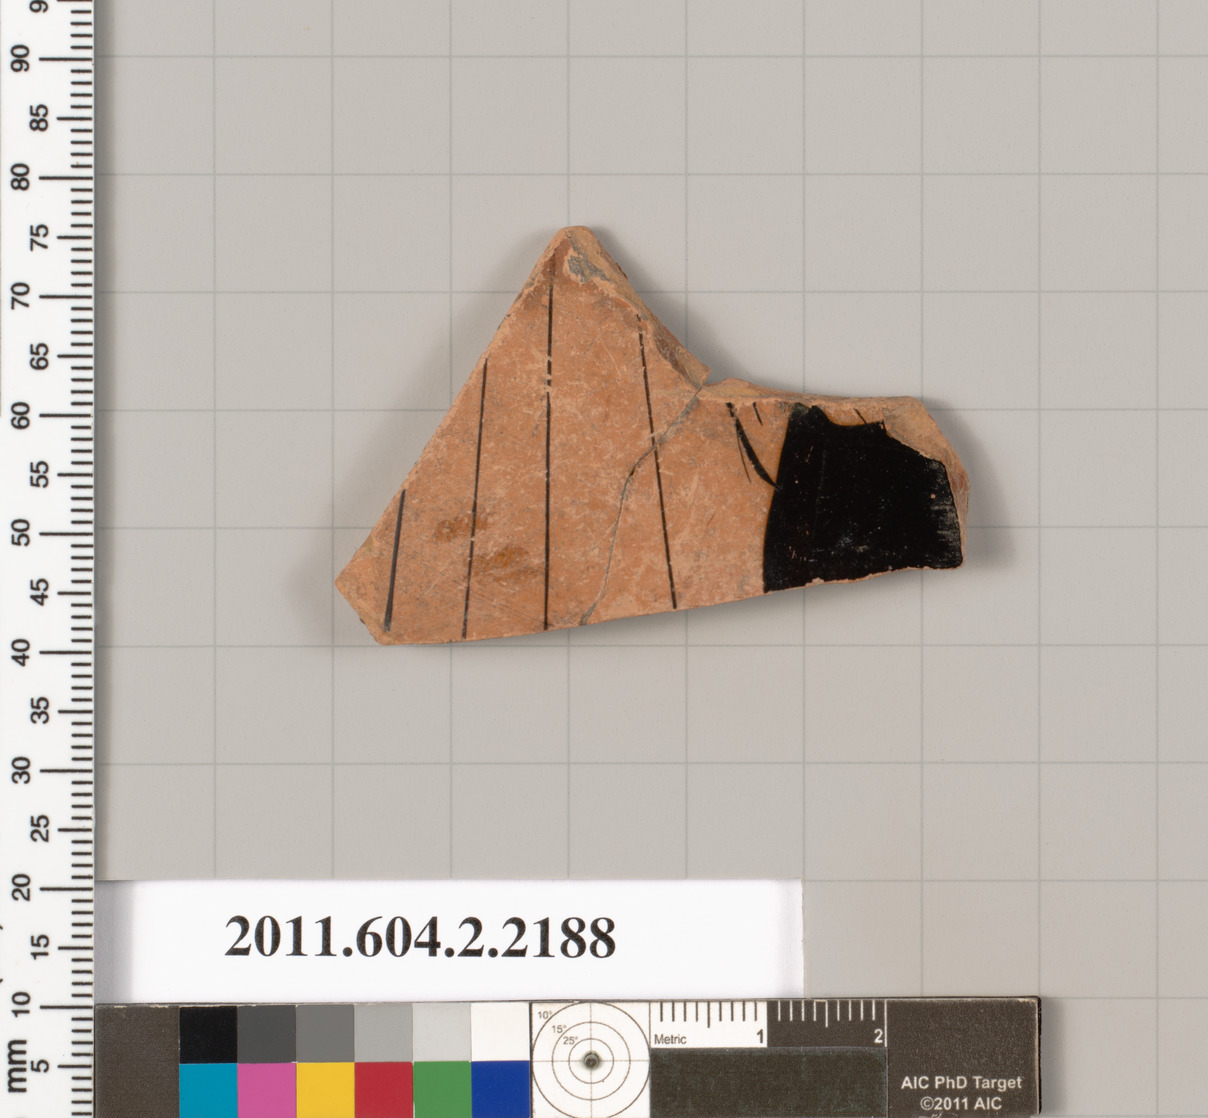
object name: pot fragment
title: Terracotta fragment of a pot; unglazed on the inside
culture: greek, attic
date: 460-440 BCE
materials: terracotta